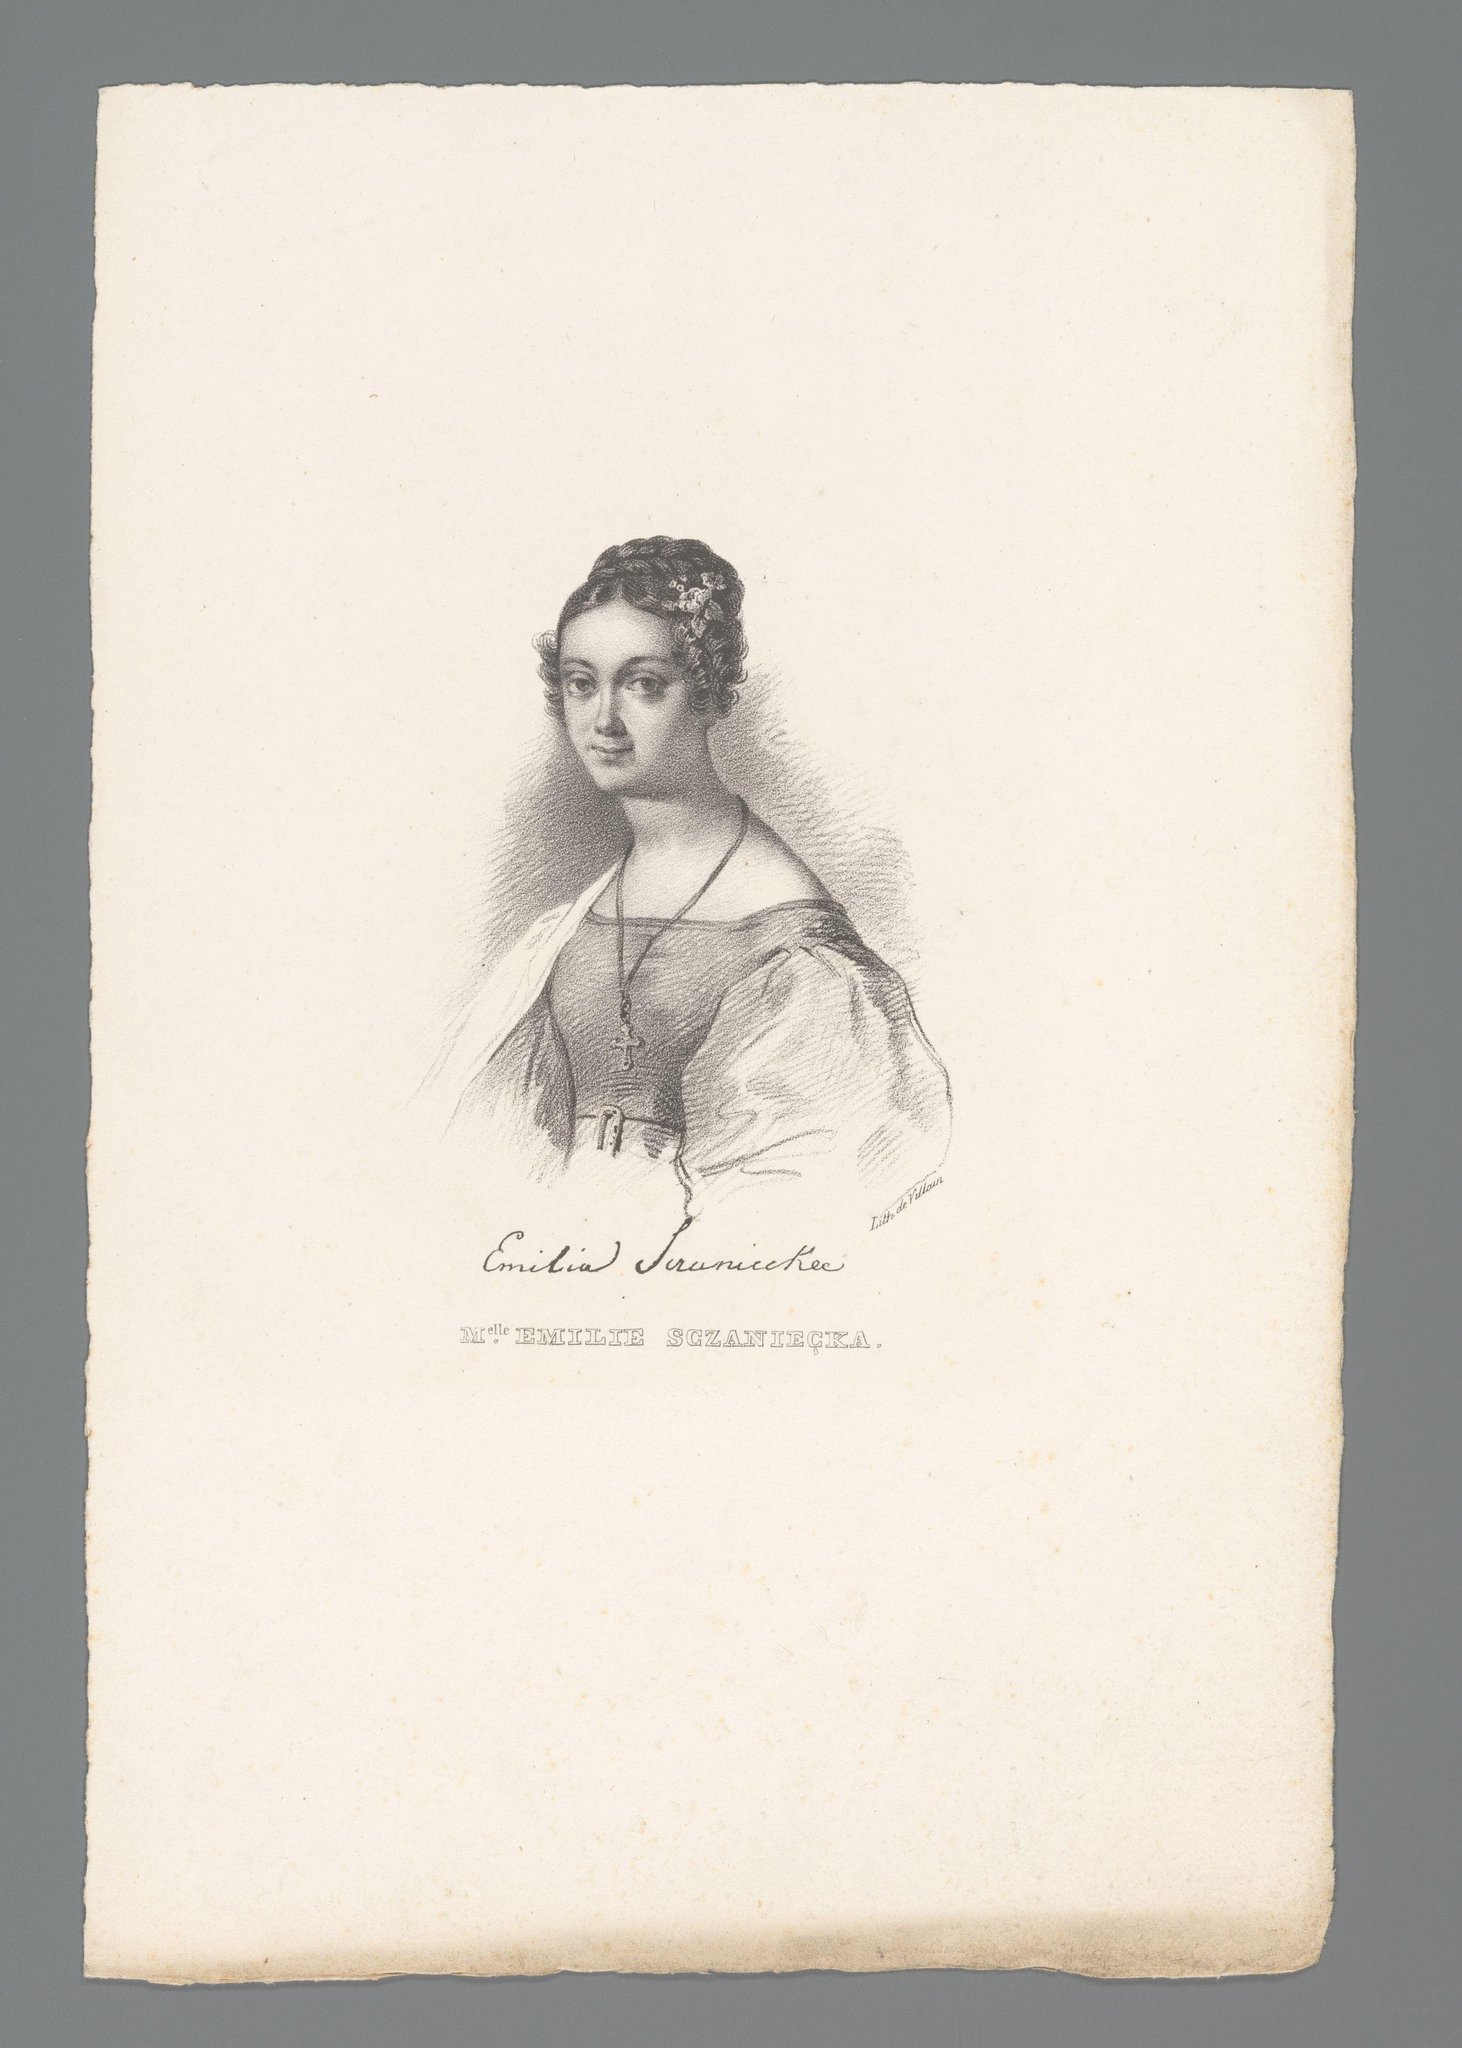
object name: print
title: Portret van Emilia Sczaniecka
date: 1832-1839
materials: paper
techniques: lithograph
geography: paris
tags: historical persons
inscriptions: collector's mark: Lugt 2228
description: Prent uit: Straszewicz., Joseph. Les polonais et les polonaises de la révolution du 29 novembre 1830, ou Portraits des personnes qui ont figuré dans la dernière guerre de l'indépendance polonaise, avec les fac-simile de leur signature, lithographiés sur dessins originaux, par les artistes les plus distingués: MM. Grévedon, Maurin, Vigneron, Belliard, Devéria, Bazin, Desmadryl, Lecler, Desmaisons, Rutowski, officier polonais, etc,. etc., accompagnés d'une biographie pour chaque portrait. Parijs: Catherine-Anaïs Pinard, 1832. Of uit: Straszewicz., Joseph. Les polonais et les polonaises de la révolution du 29 novembre 1830. Biographie des personnes qui ont figuré dans la dernière guerre de l'indépendance polonaise, avec les fac-simile de leur signature, ornée de 30 portraits lithographiés sur dessins originaux, par les artistes les plus distingués: MM. Grévedon, Maurin, Vigneron, Belliard, Devéria, Bazin, Desmadryl, Lecler, etc., etc.. Parijs: s.n., 1839.